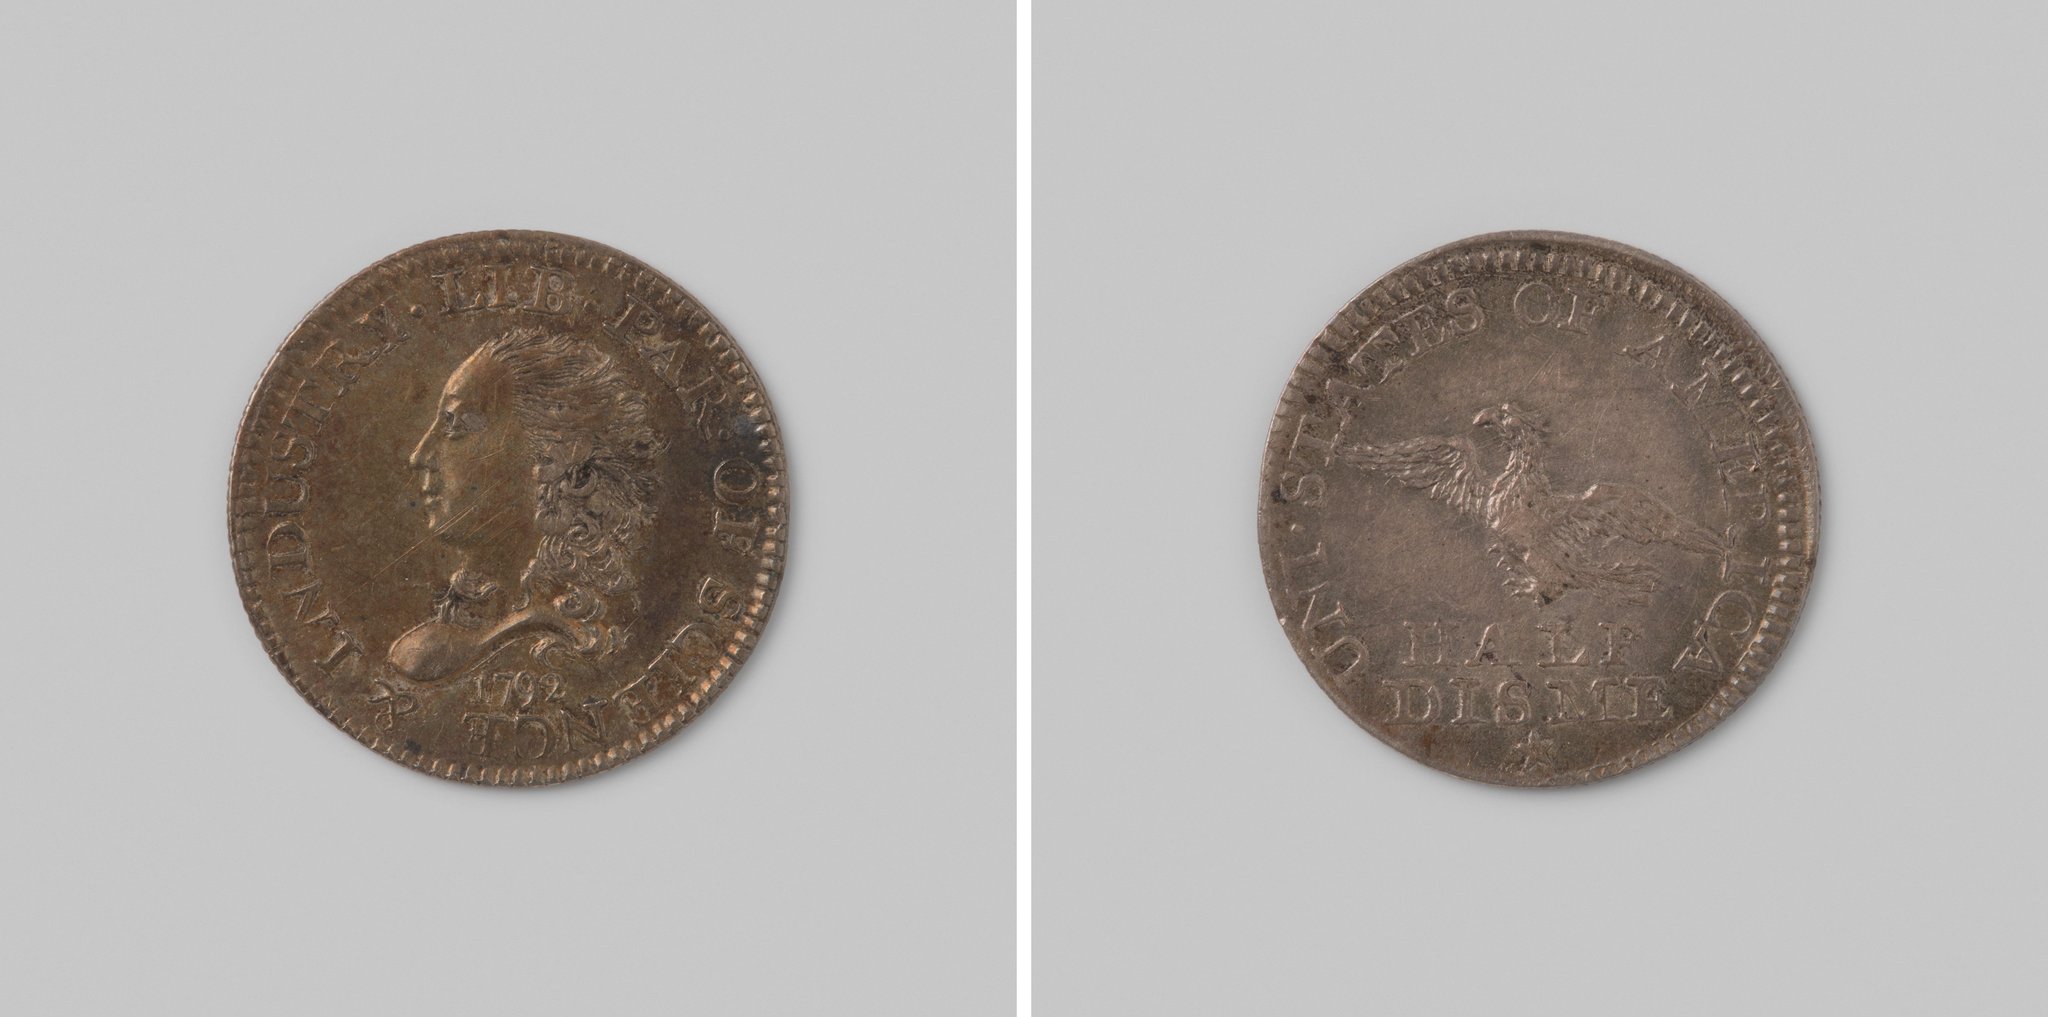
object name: coin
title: Verenigde Staten van Amerika, ½ disme (dime) of 5 cents, 1792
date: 1792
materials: silver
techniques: striking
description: Zilveren munt. Voorzijde: borstbeeld van de echtgenote van Washington naar links, daaronder jaartal. Keerzijde: vliegende adelaar naar links. Daaronder waarde-aanduiding: half disme. Kabelrand.